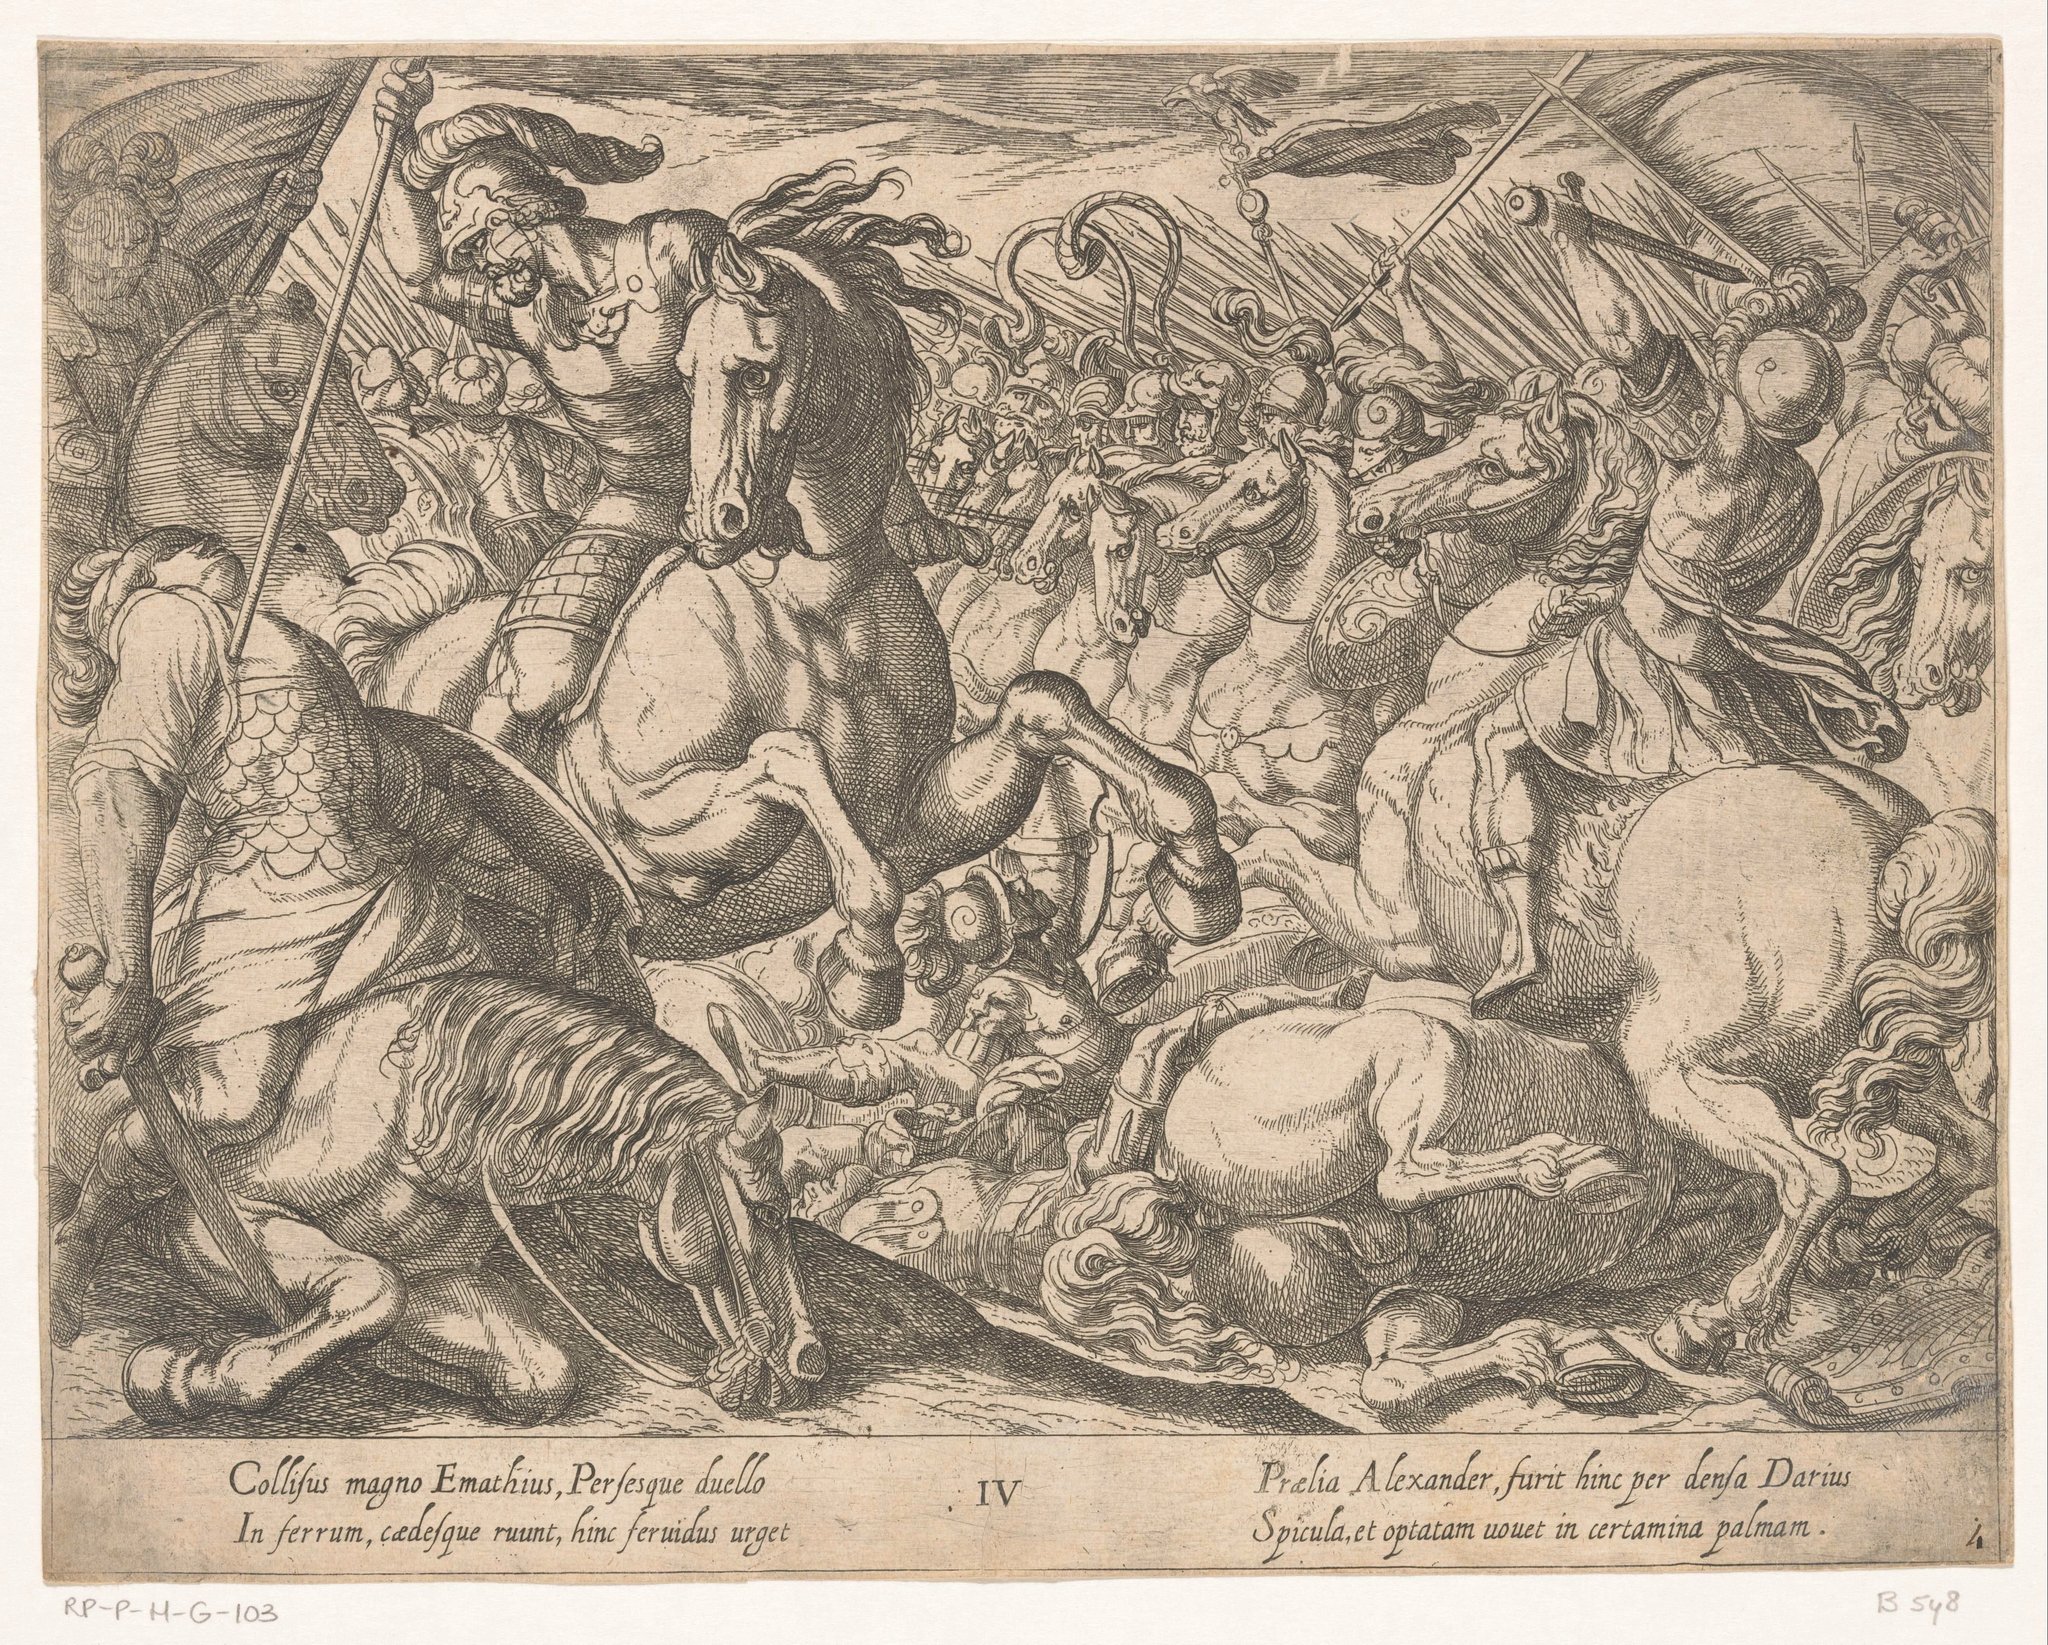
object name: print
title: De daden van Alexander de Grote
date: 1608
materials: paper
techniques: etching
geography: italy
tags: battles of alexander, battle, warfare; military affairs (+ cavalry, horsemen), the soldier; the soldier's life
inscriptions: number: ‘4’, collector's mark: ‘Hinloopen’, collector's mark: Lugt 11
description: Een strijdgewoel van soldaten te paard. Het leger van Alexander de Grote in gevecht met de Perzen. Vierregelig vers in het Latijn in twee kolommen in ondermarge.